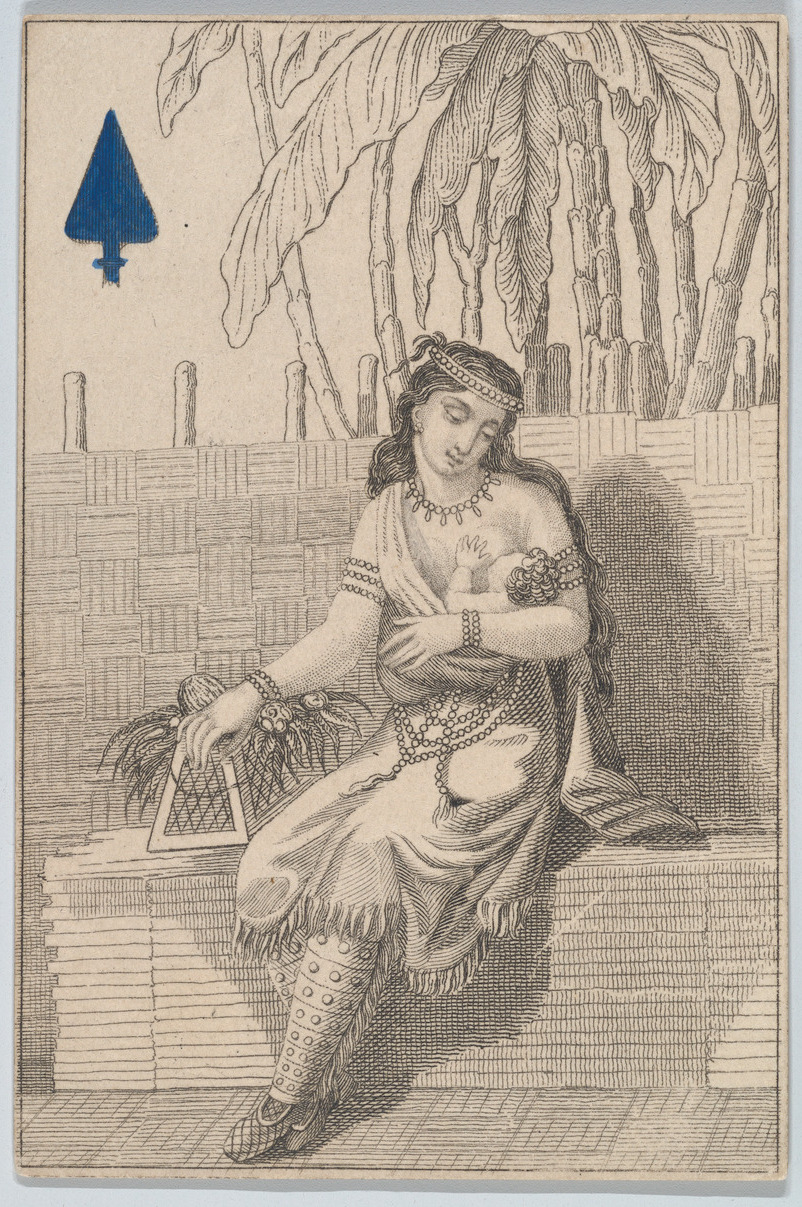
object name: print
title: Queen (Neala from Canada), from "Court Game of Geography"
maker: william and henry rock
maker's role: publisher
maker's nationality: british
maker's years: 1821-1884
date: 1838-1855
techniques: engraving, etching, hand coloring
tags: infants,women,playing cards,nursing